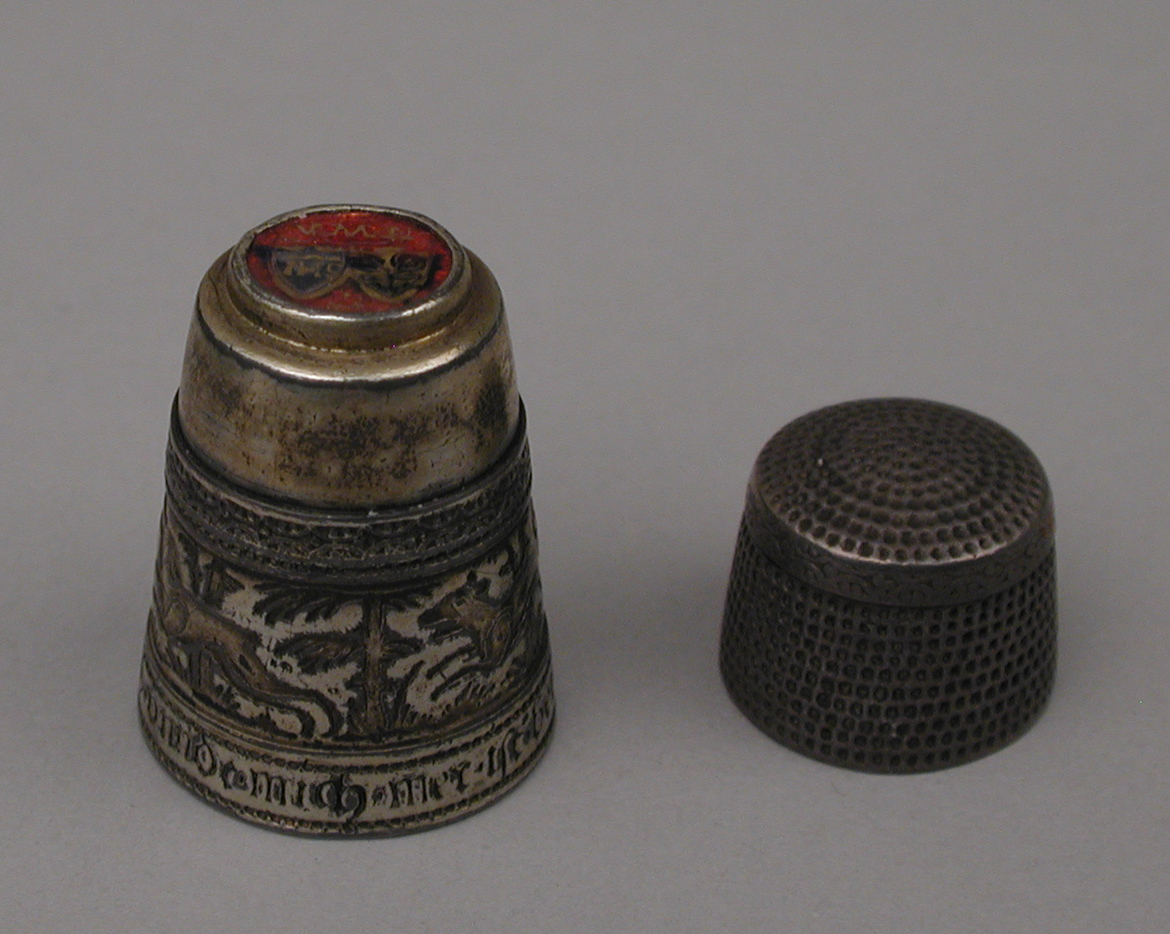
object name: thimble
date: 1577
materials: enamel, gilt, silver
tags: animals,coat of arms